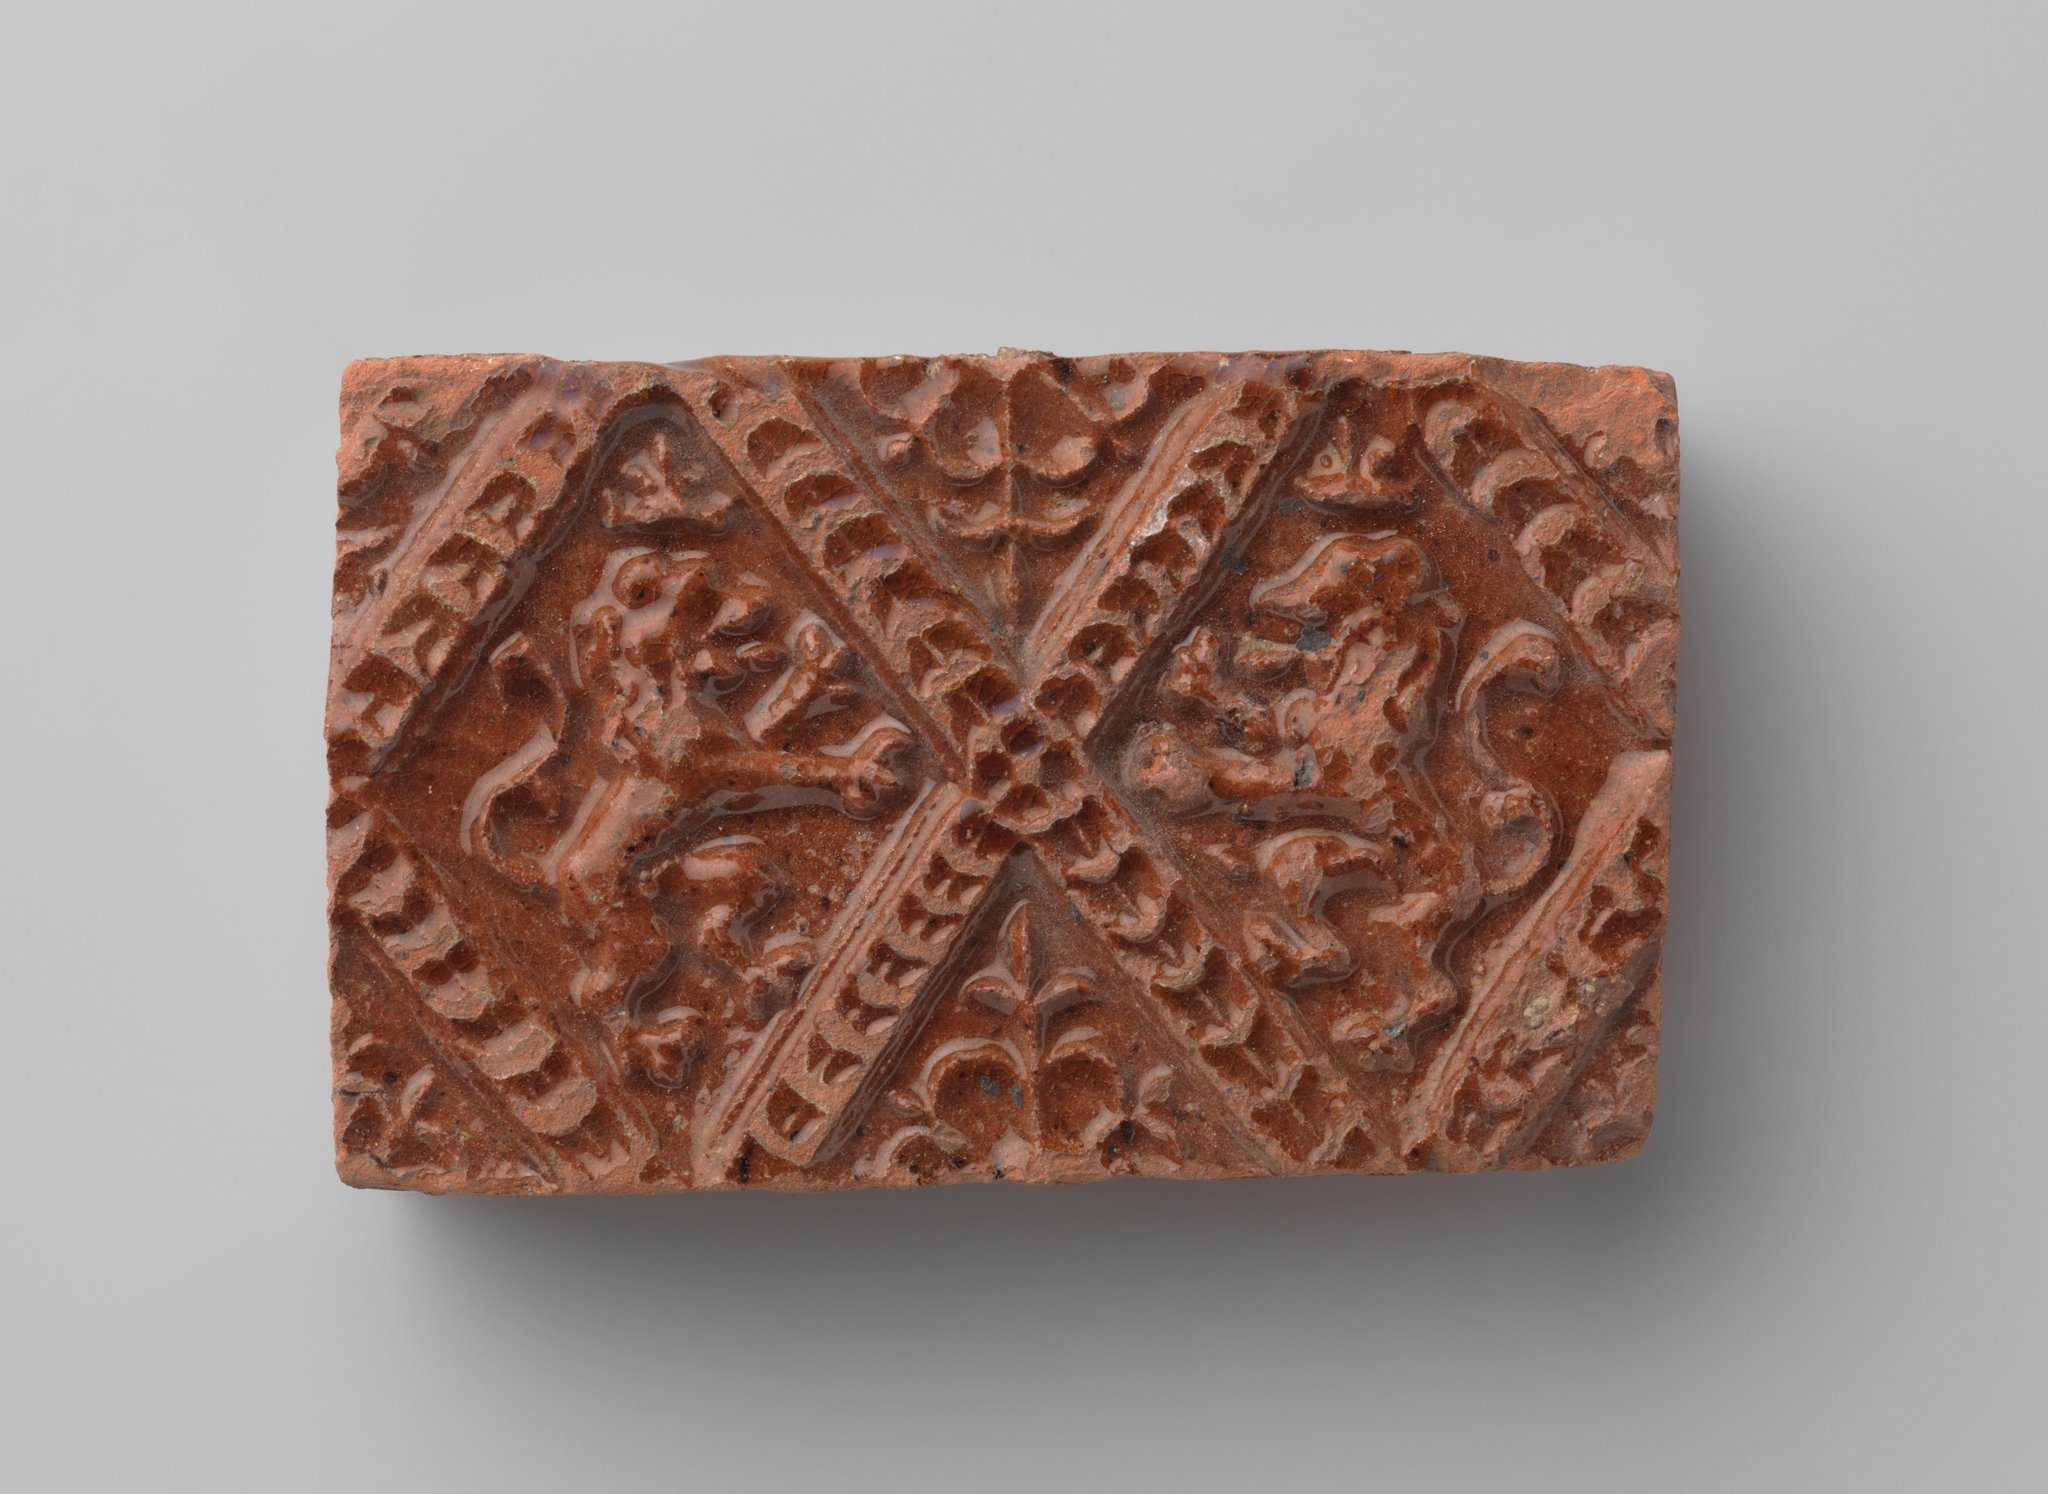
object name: hearthstone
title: Haardsteen met voorstelling van twee klimmende leeuwen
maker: Anonymous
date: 1875-1900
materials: earthenware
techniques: printing, firing, vitrification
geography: netherlands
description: Haardsteen met voorstelling van twee klimmende leeuwen, geplaatst in geprofileerde ruit. De halve ruiten aan de boven- en onderkant zijn opgevuld met pijlmotief. Geglazuurd.